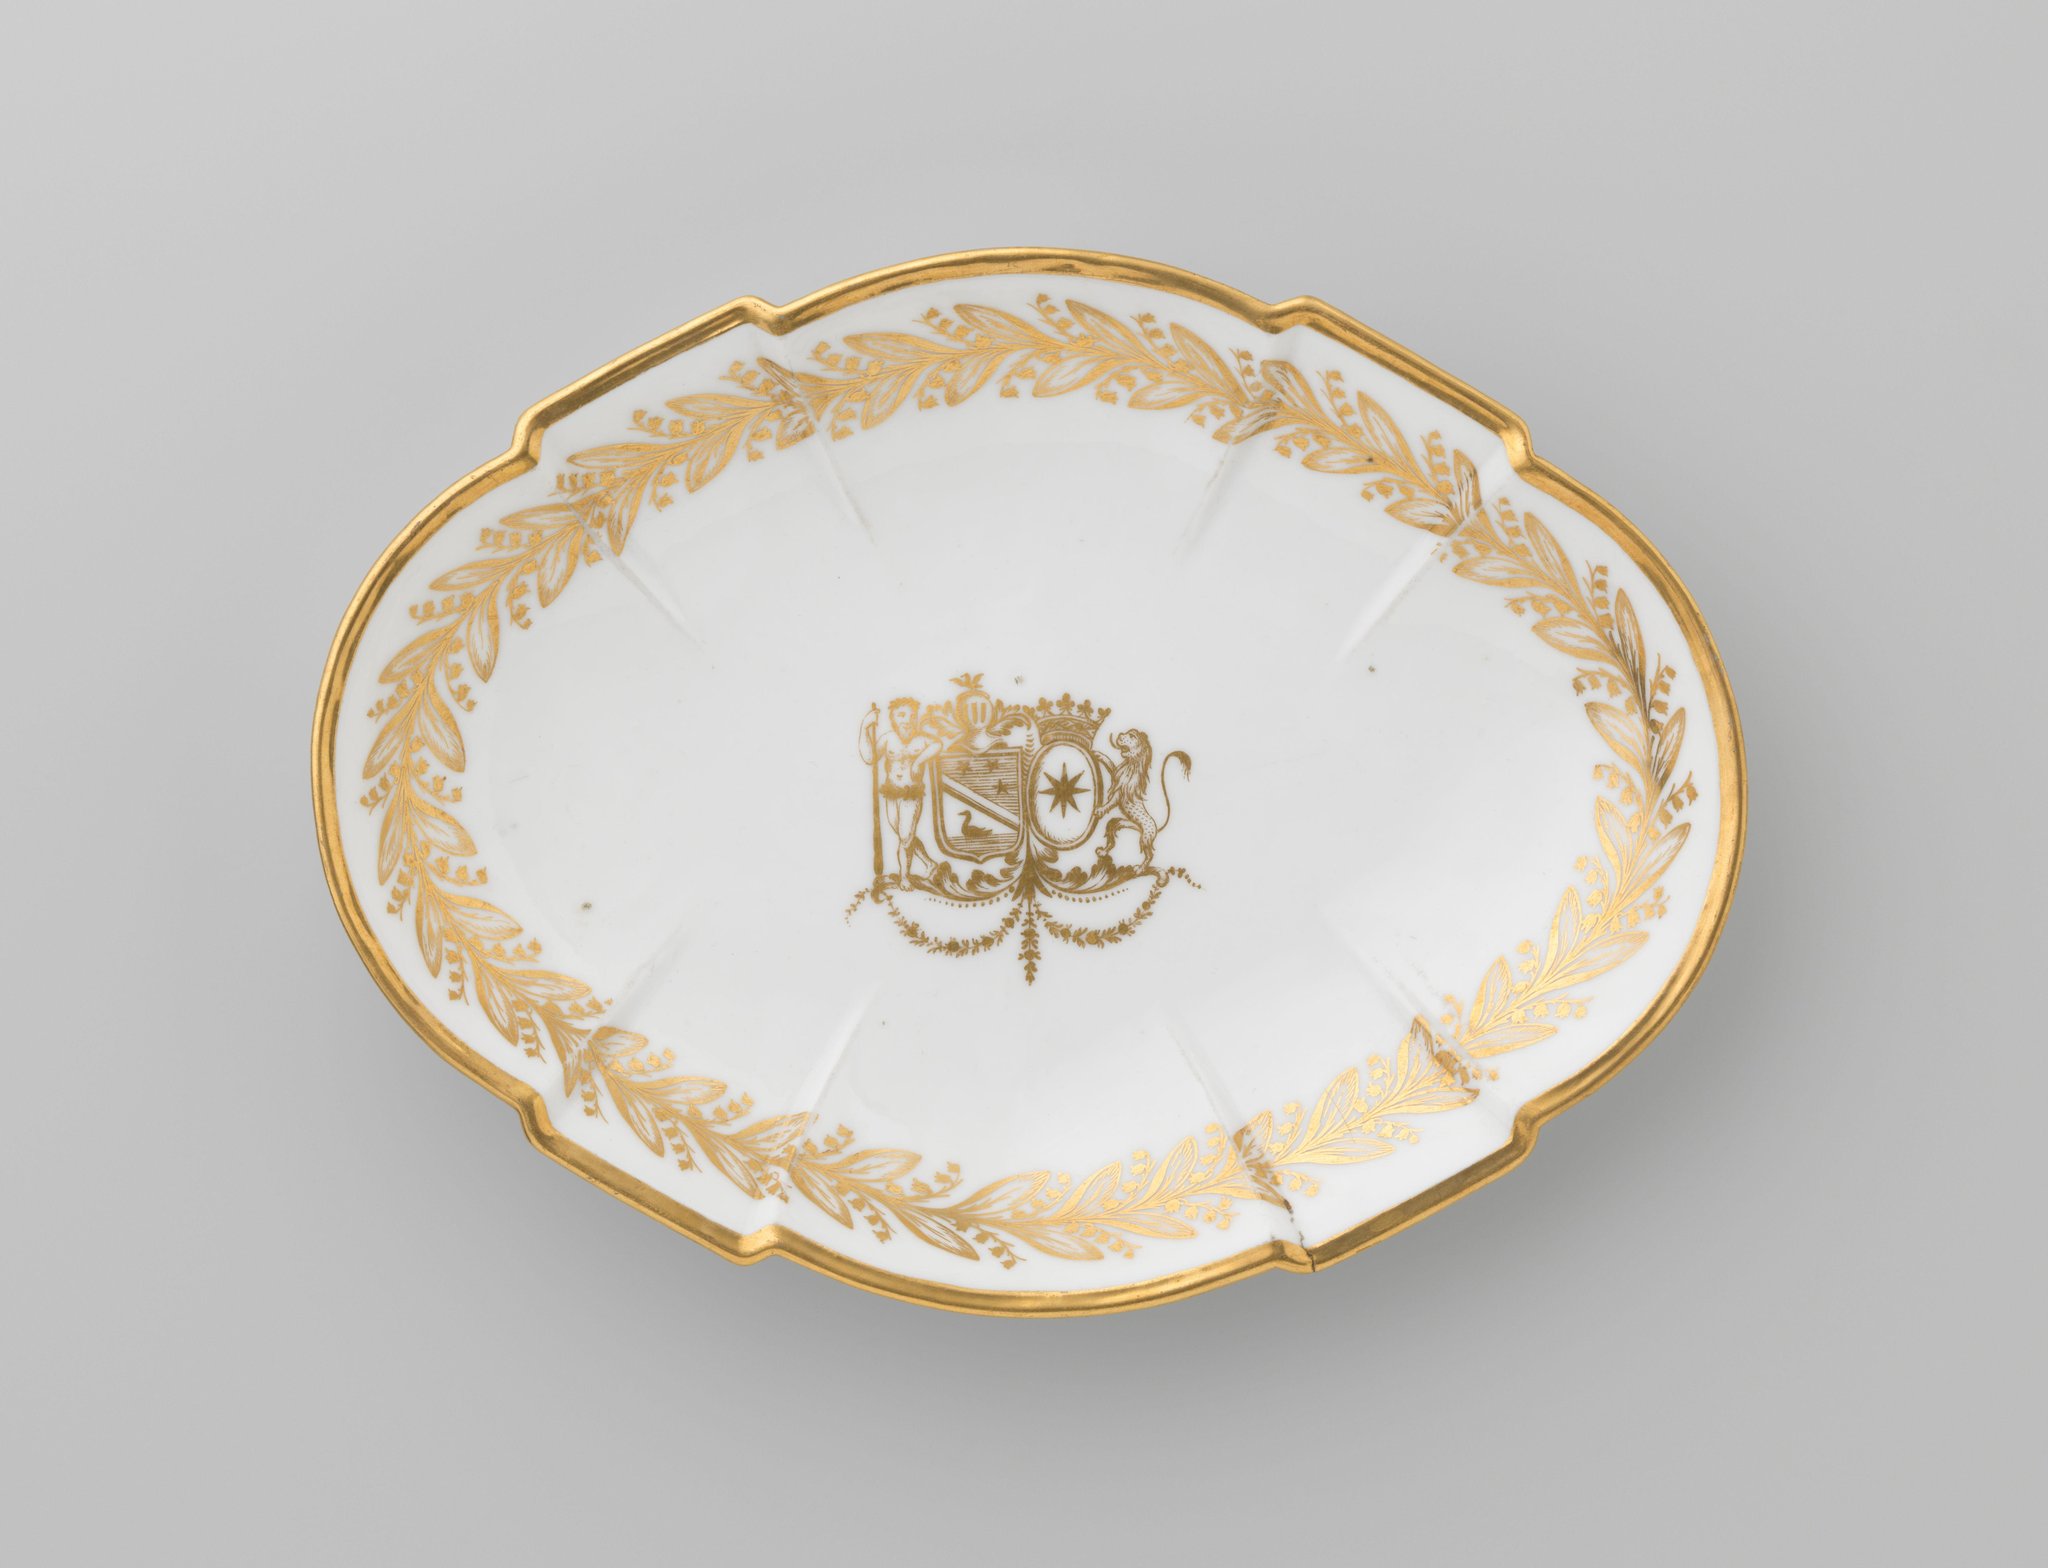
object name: dish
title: Dish with the coat of arms of Hendrik Peter Godfried Quack and Isabella Gertraud von Carnap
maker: Anonymous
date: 1790-1800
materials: glaze, gold, paint, porcelain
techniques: firing, forming, gilding, turning, vitrification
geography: netherlands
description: Ovale schaal van porselein met vier rechthoekige ribben in de wand, beschilderd op het glazuur met goud. Op het plat het alliantiewapen van Hendrik Peter Godfried Quack en Isabella Gertraud von Carnap. De binnenwand met een bloemrank en een gouden band op de rand. Drie proenen op de onderzijde.